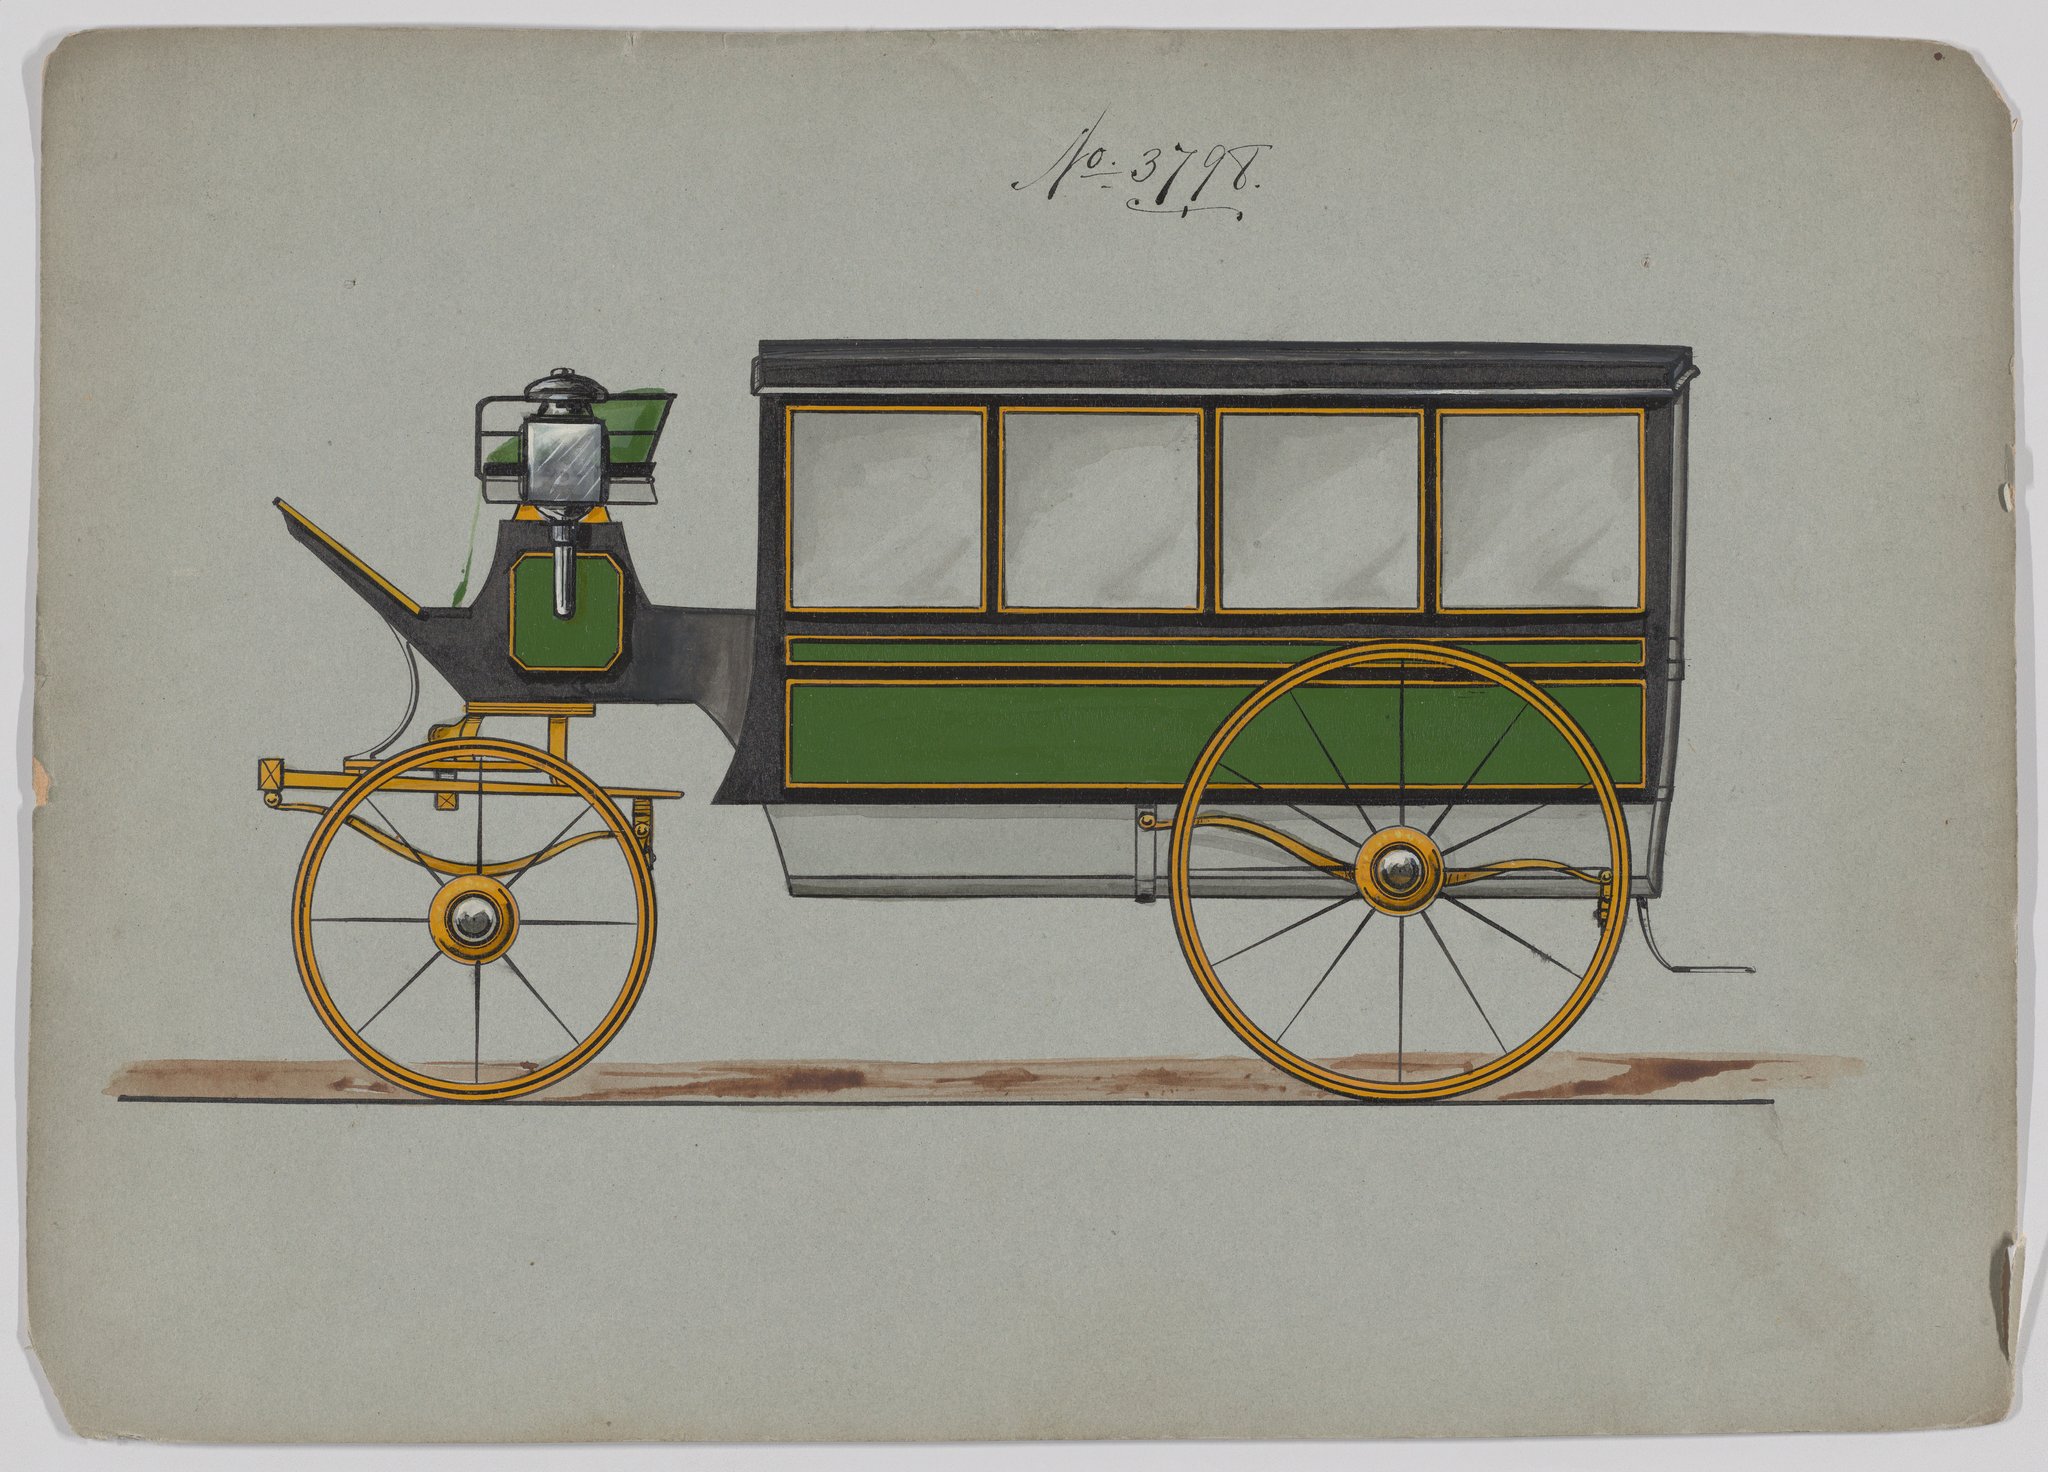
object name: drawing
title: Omnibus #3798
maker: brewster & co.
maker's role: manufacturer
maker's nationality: american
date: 1883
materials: gouache, gum arabic, ink, watercolor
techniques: pen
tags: carriages